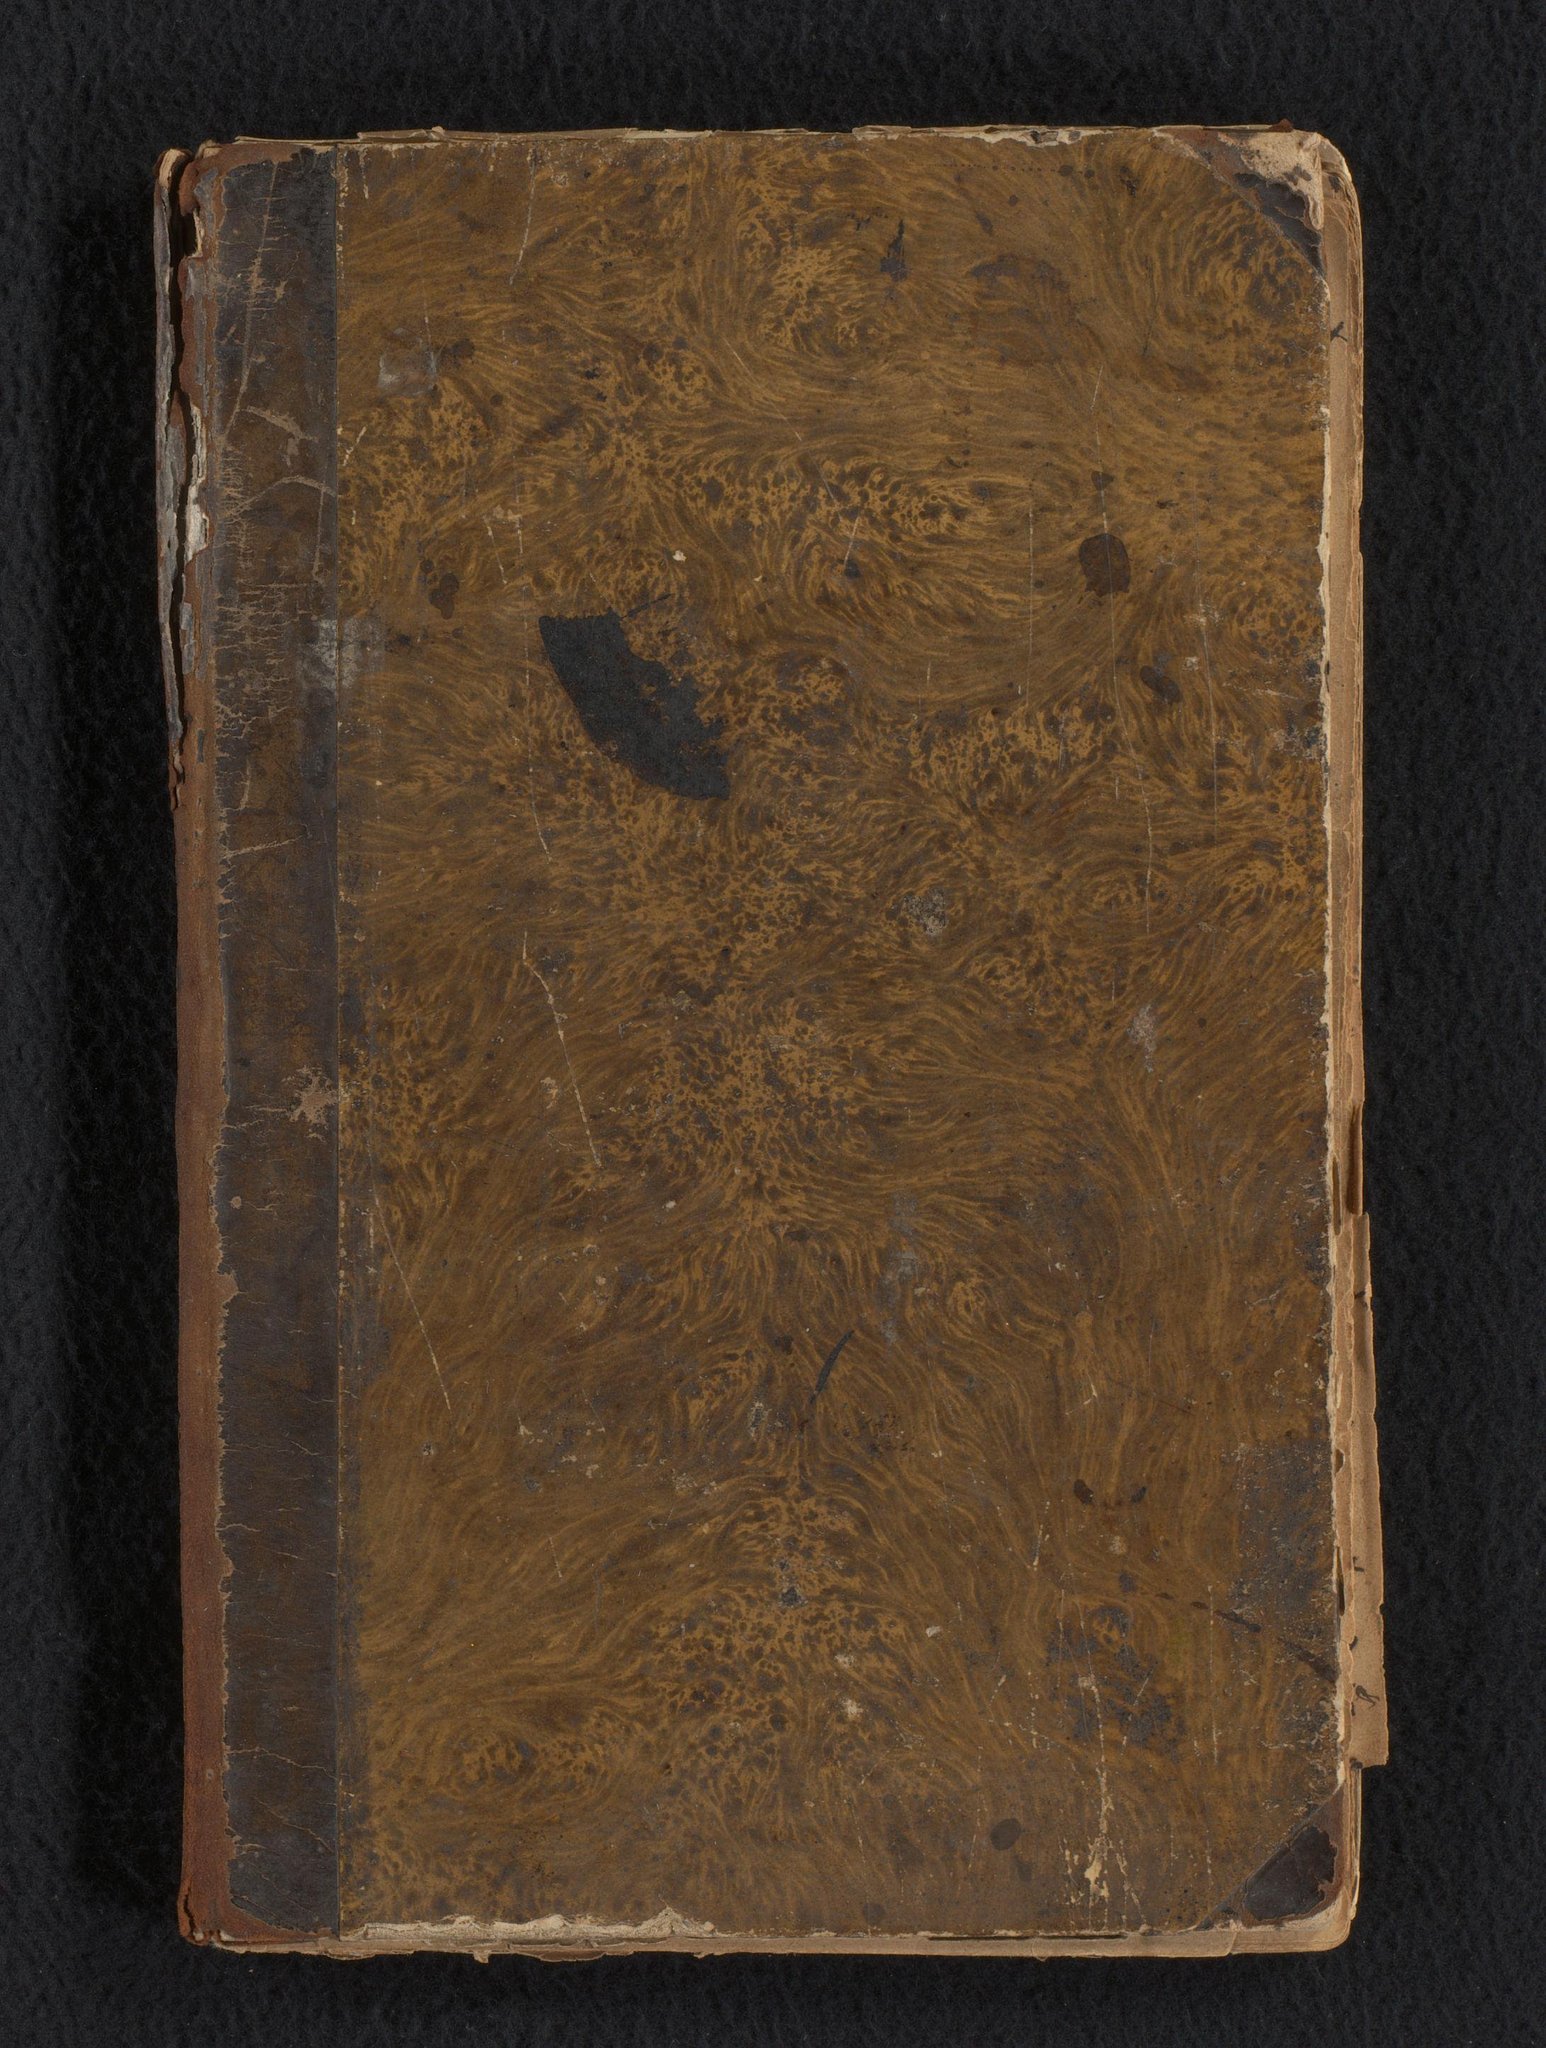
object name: book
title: Kasboek van de fotograaf Johan Wouters over de jaren 1889-1896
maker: johan wouters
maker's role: auteur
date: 1889-1896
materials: cardboard, ink, leather, paper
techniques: printing, pen, marbling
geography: rotterdam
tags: administration ~ trade and finance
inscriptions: stamp: ‘JOHAN WOUTERS/ Schilder & Photograaf/ ROTTERDAM./ Crispijnlaan 13 b, S. Westerkerk’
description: Kasboek van de Rotterdamse fotograaf Johan Wouters over de jaren 1889 tot en met 1896 met daarin een maandelijks overzicht van geportretteerde mensen en daarbij behorende inkomsten, en een overzicht per jaar van uitgaven voor materiaal en belastingen.